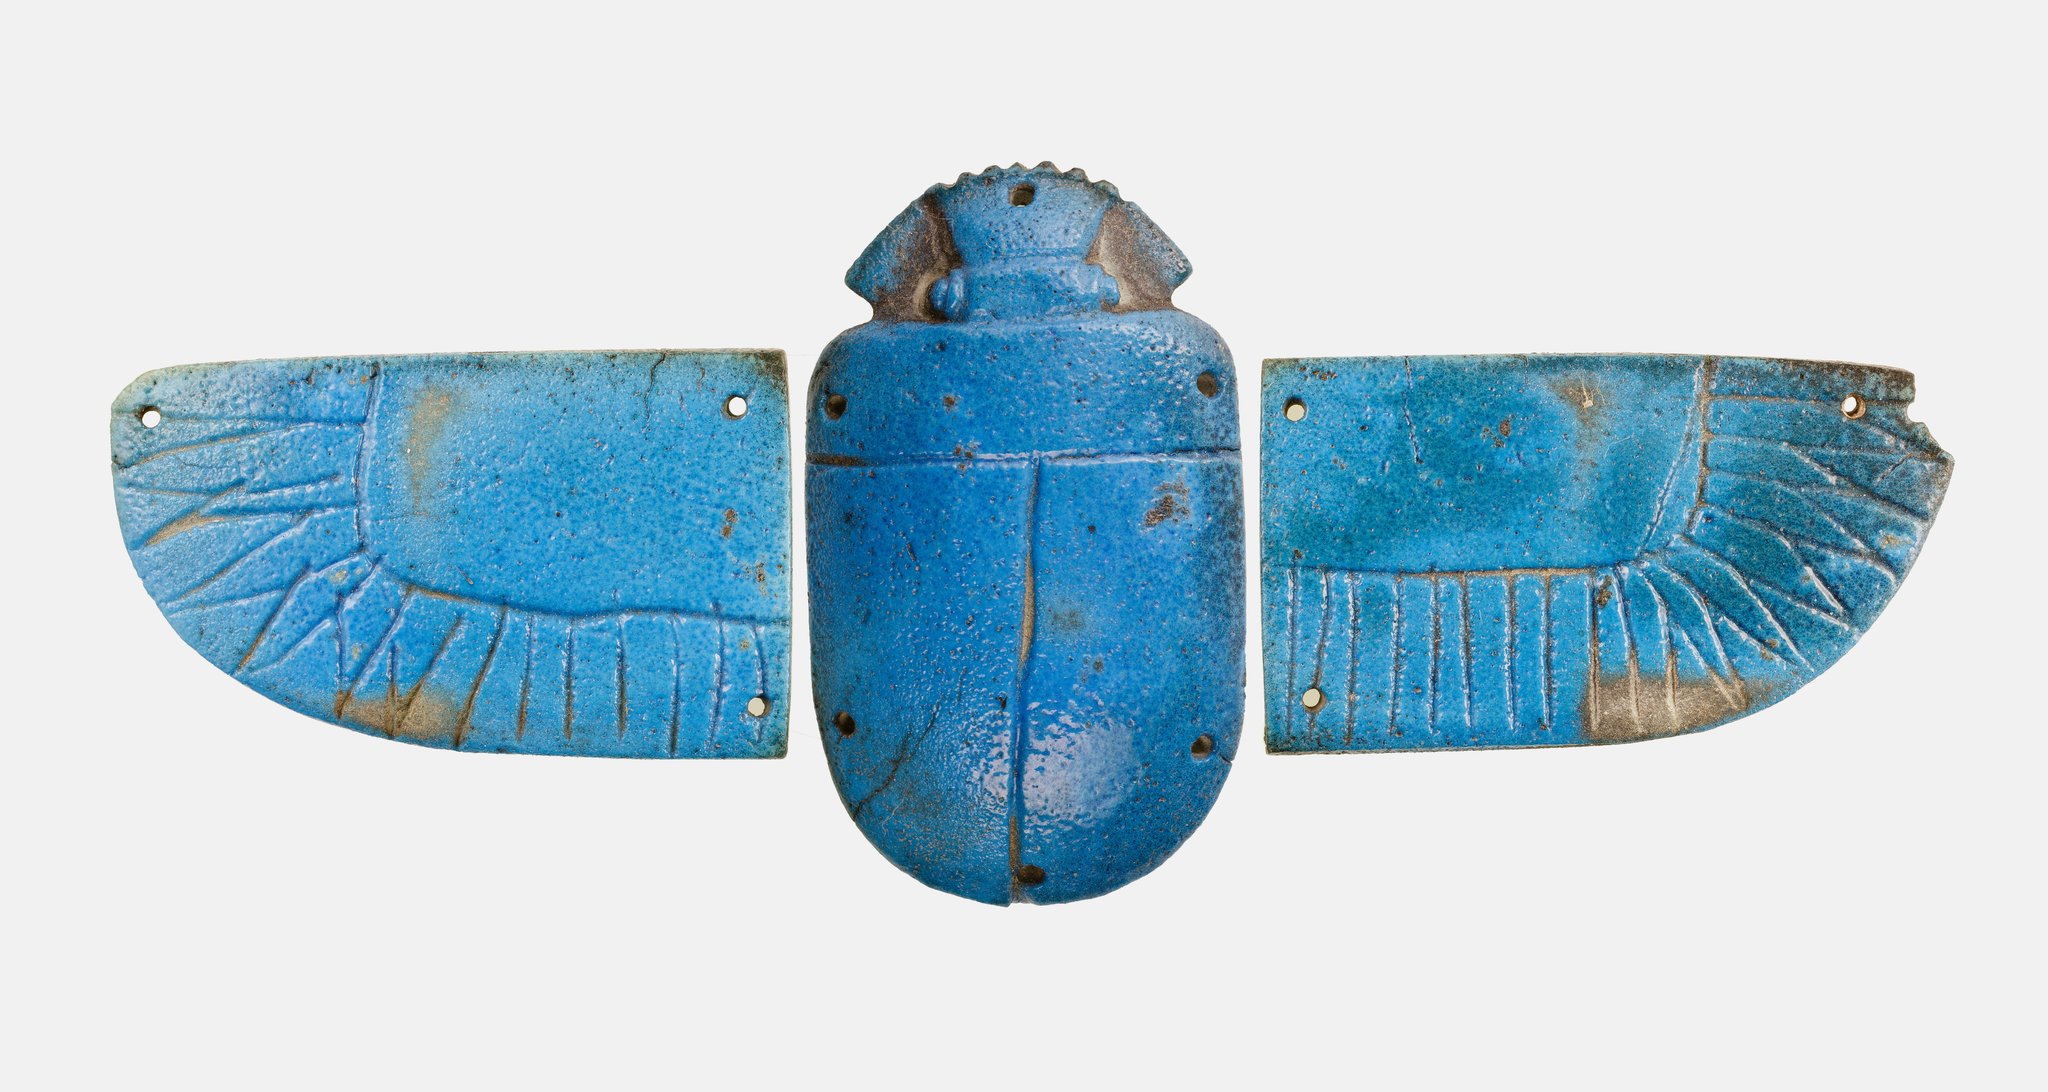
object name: amulet, winged scarab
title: Scarab with Wings from Bead Net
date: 1070-525 BCE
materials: faience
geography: egypt